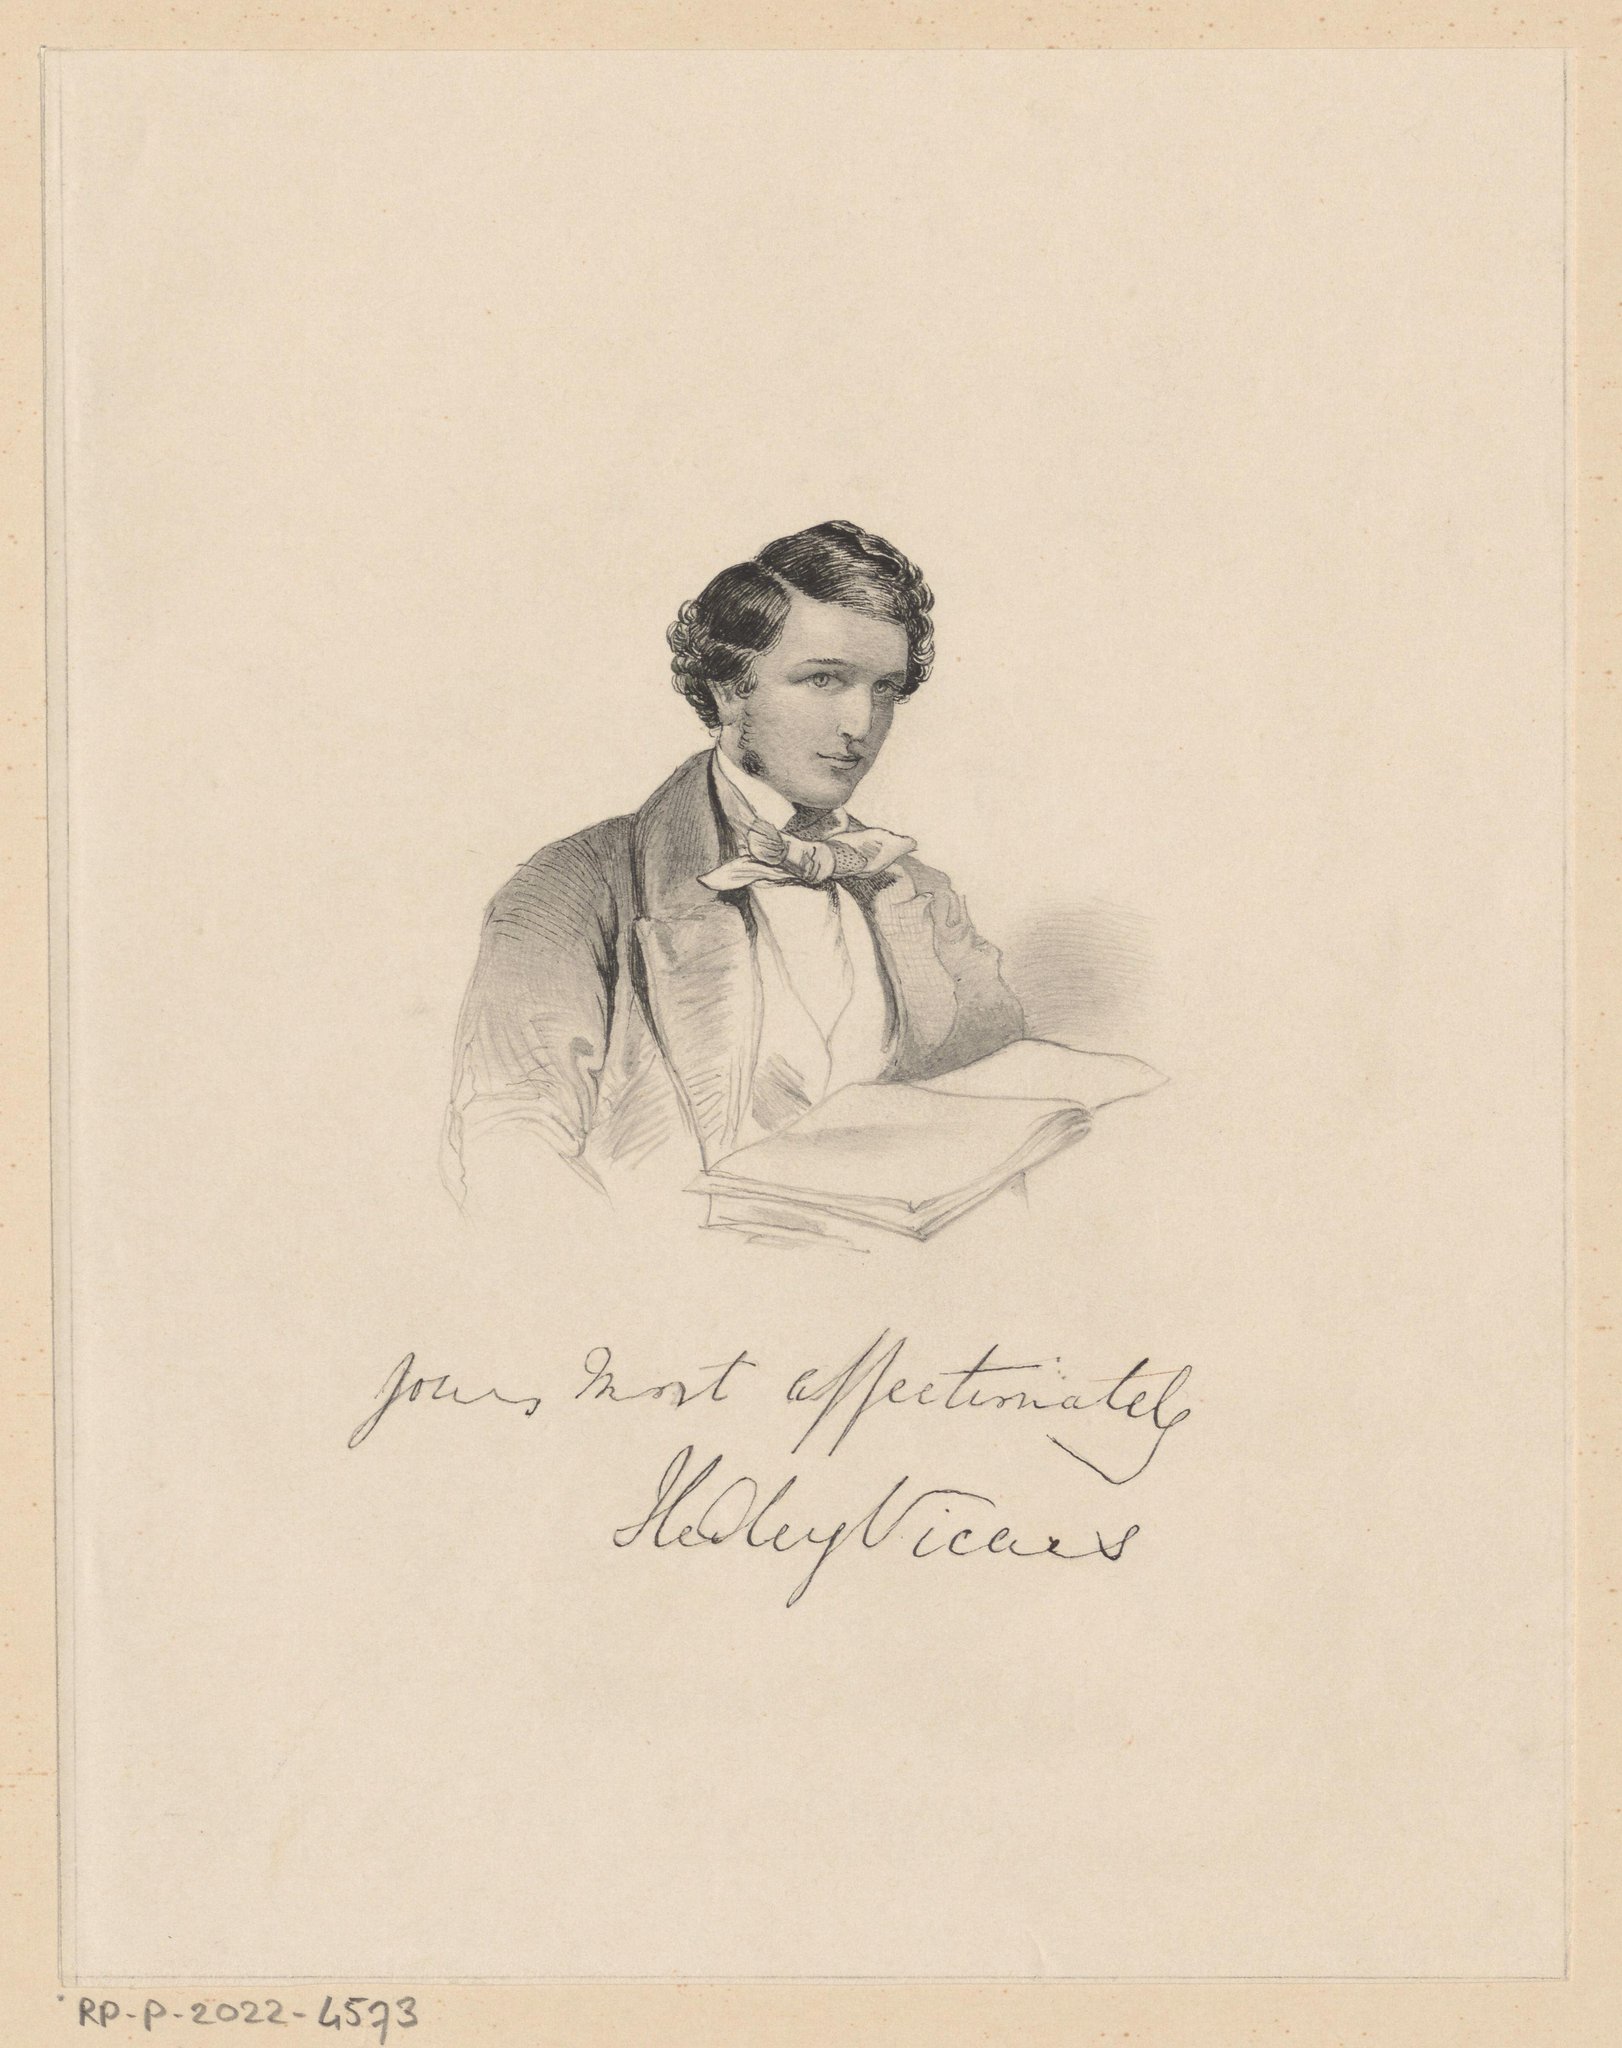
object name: print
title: Portret van Hedley Vicars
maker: Anonymous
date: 1850-1870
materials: paper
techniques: lithograph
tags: commander-in-chief, general, marshal, historical persons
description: Prent mogelijk uit een editie van: Marsh, Catherine. Memorials of Captain Hedley Vicars, Ninety-seventh Regiment. Londen: James Nisbet, 1856.